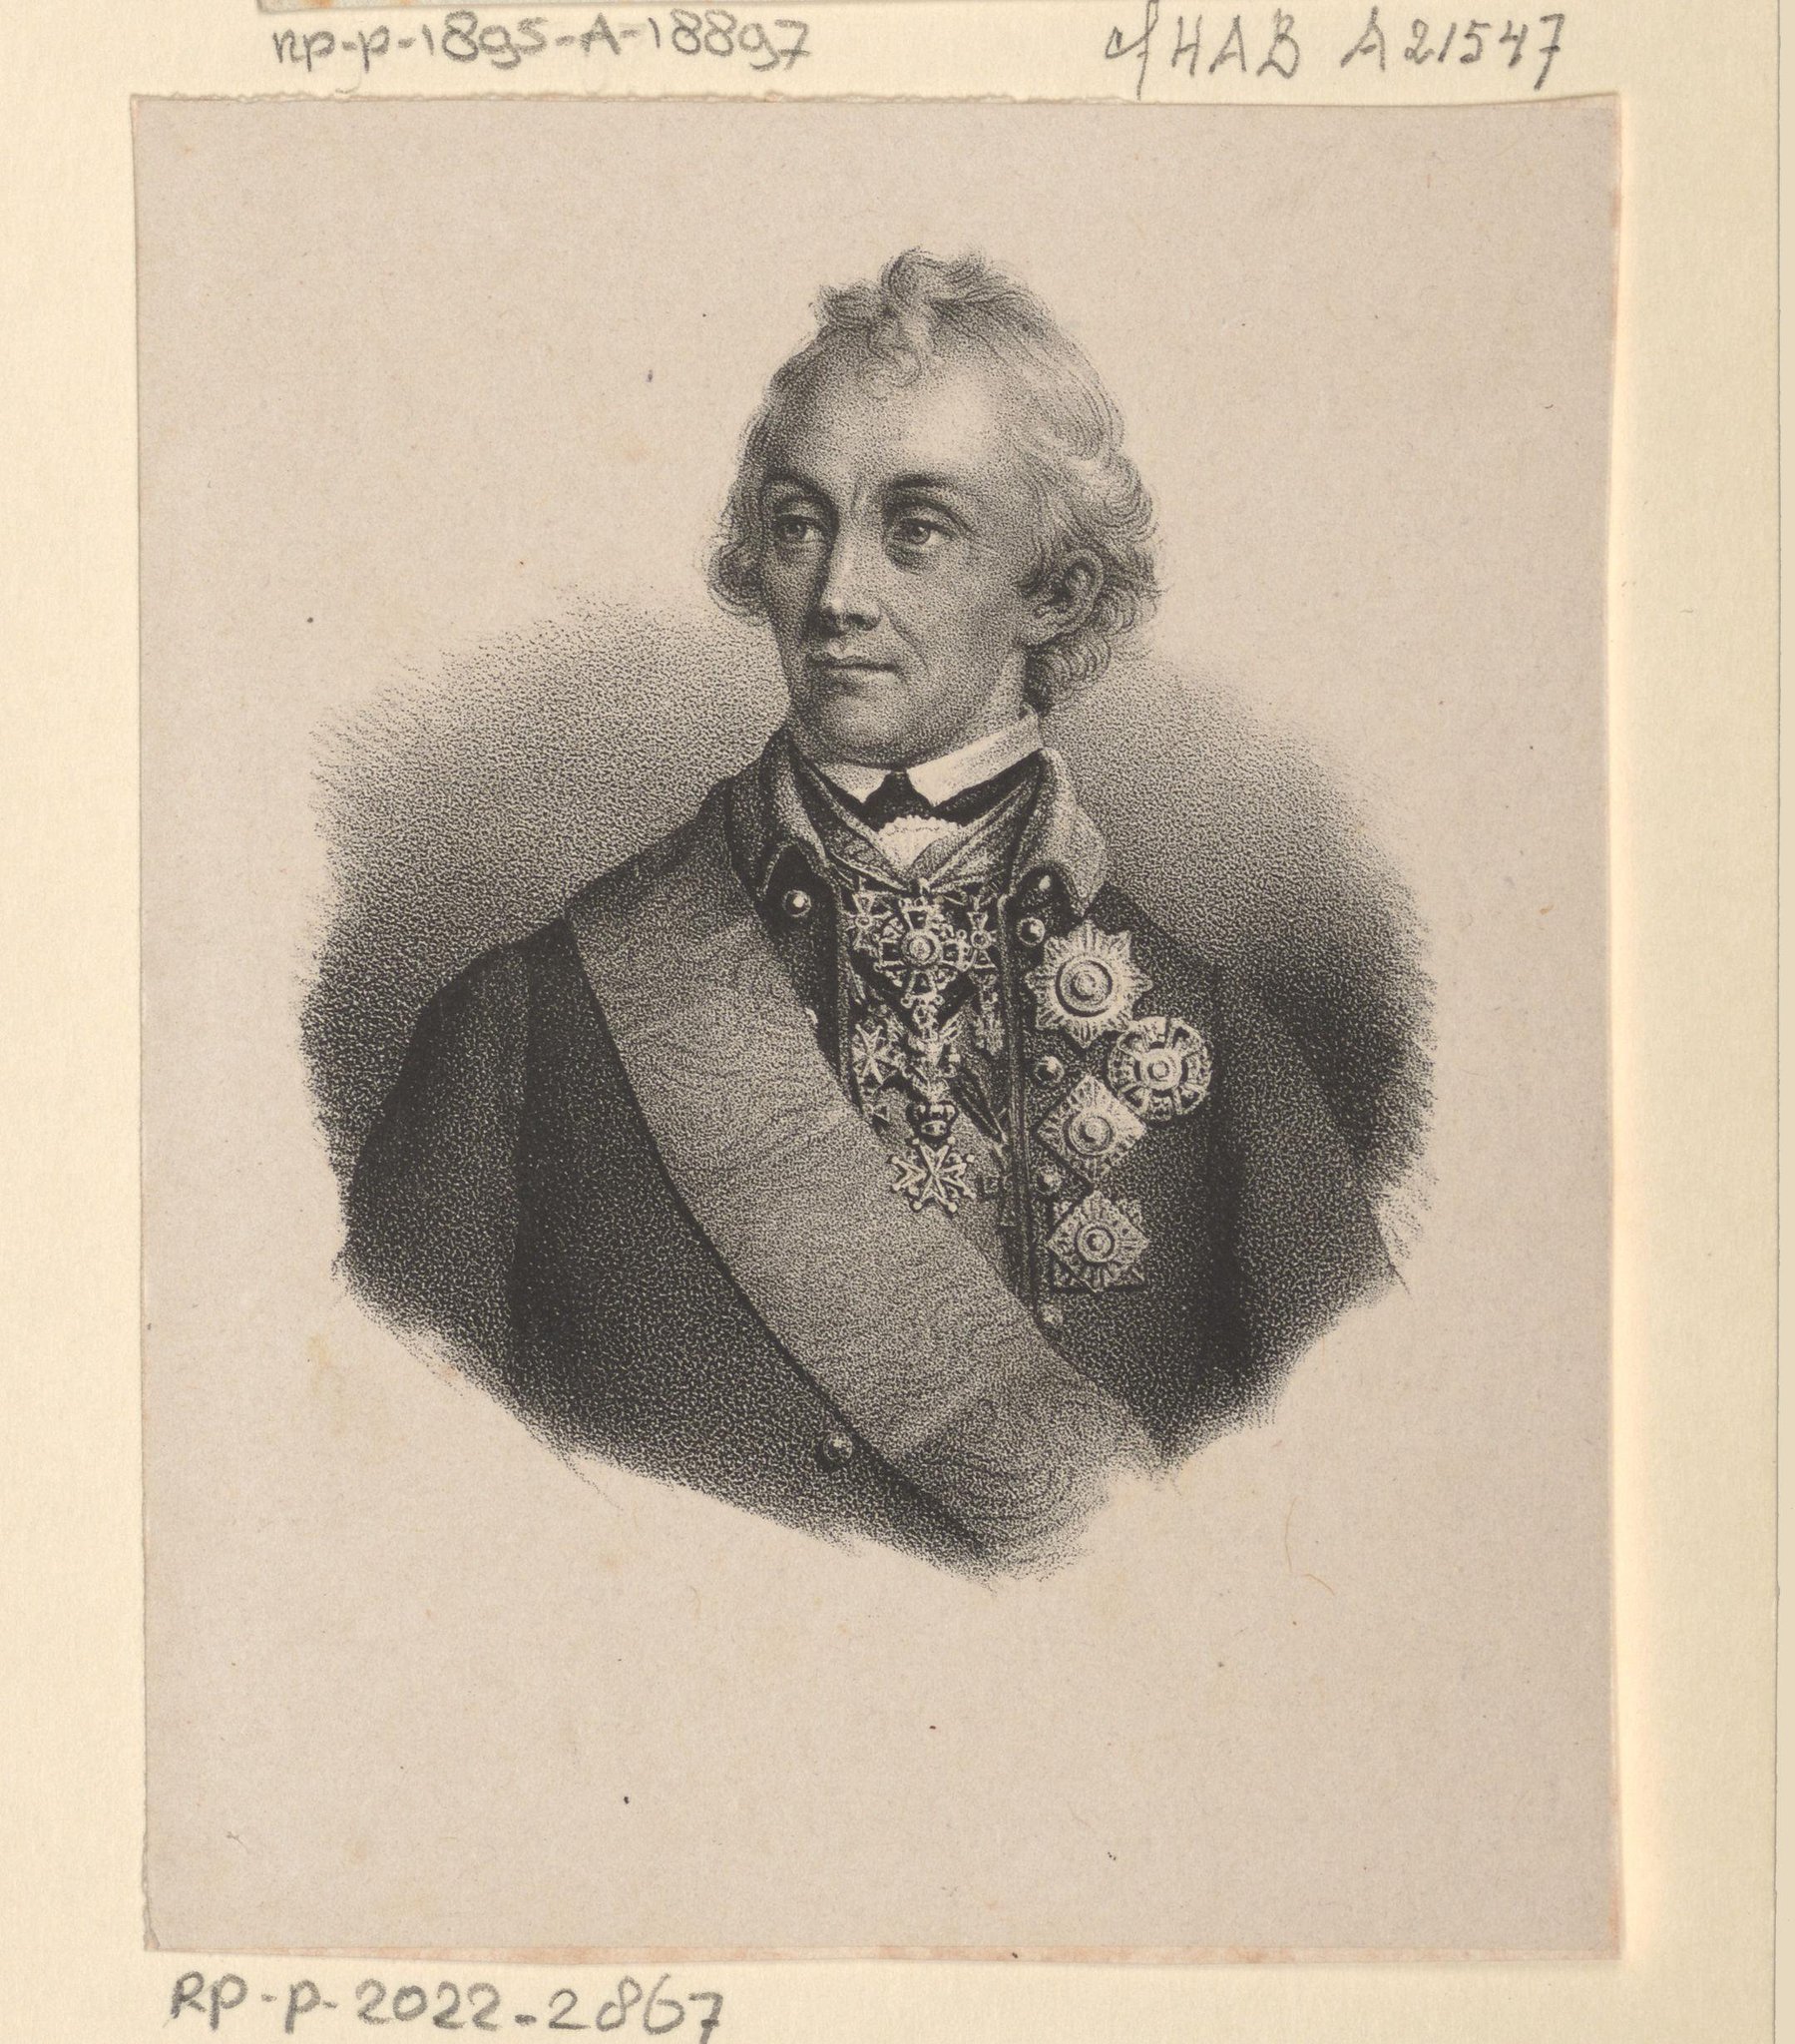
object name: print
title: Portret van Aleksandr Soevorov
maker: Anonymous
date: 1798-1899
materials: paper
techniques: lithograph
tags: commander-in-chief, general, marshal, historical persons